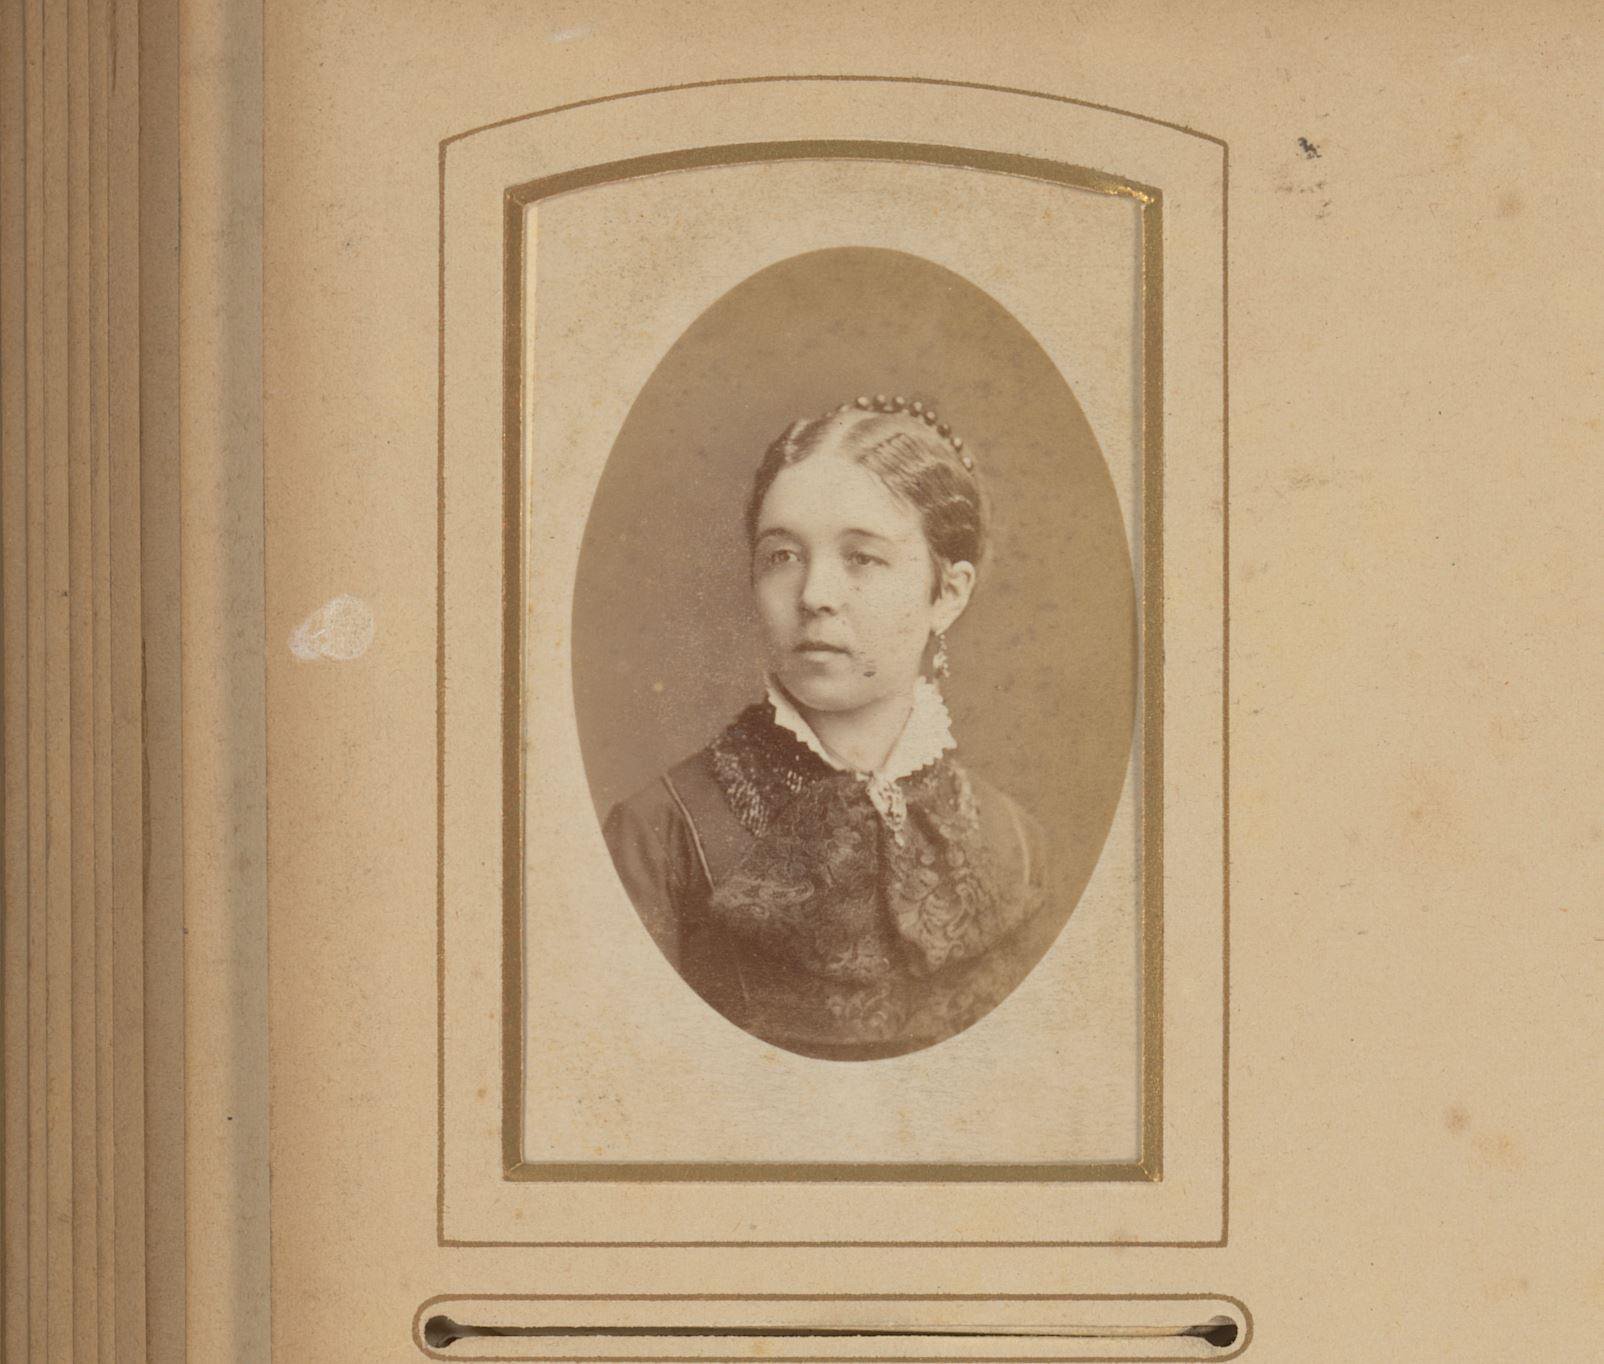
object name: album leaf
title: Portret van een jonge vrouw met oorbellen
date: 1899-1908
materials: cardboard, photographic support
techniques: albumen print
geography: leuven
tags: adolescent, young woman, maiden, historical persons - bb - woman, ear-rings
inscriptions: inscription: ‘PHOTOGRAPHIE INALTÉRABLE/ Procédé au Chabron/ PHOTOGRAPHIE/ DE/ Verbeke Schodts Fils/ 20, Rue de Bruxelles/ LOUVAIN/ Le Cliché étant conservé, il suffit de/ rappeler le nom pour obtenir des mêmes/ Cartes.’